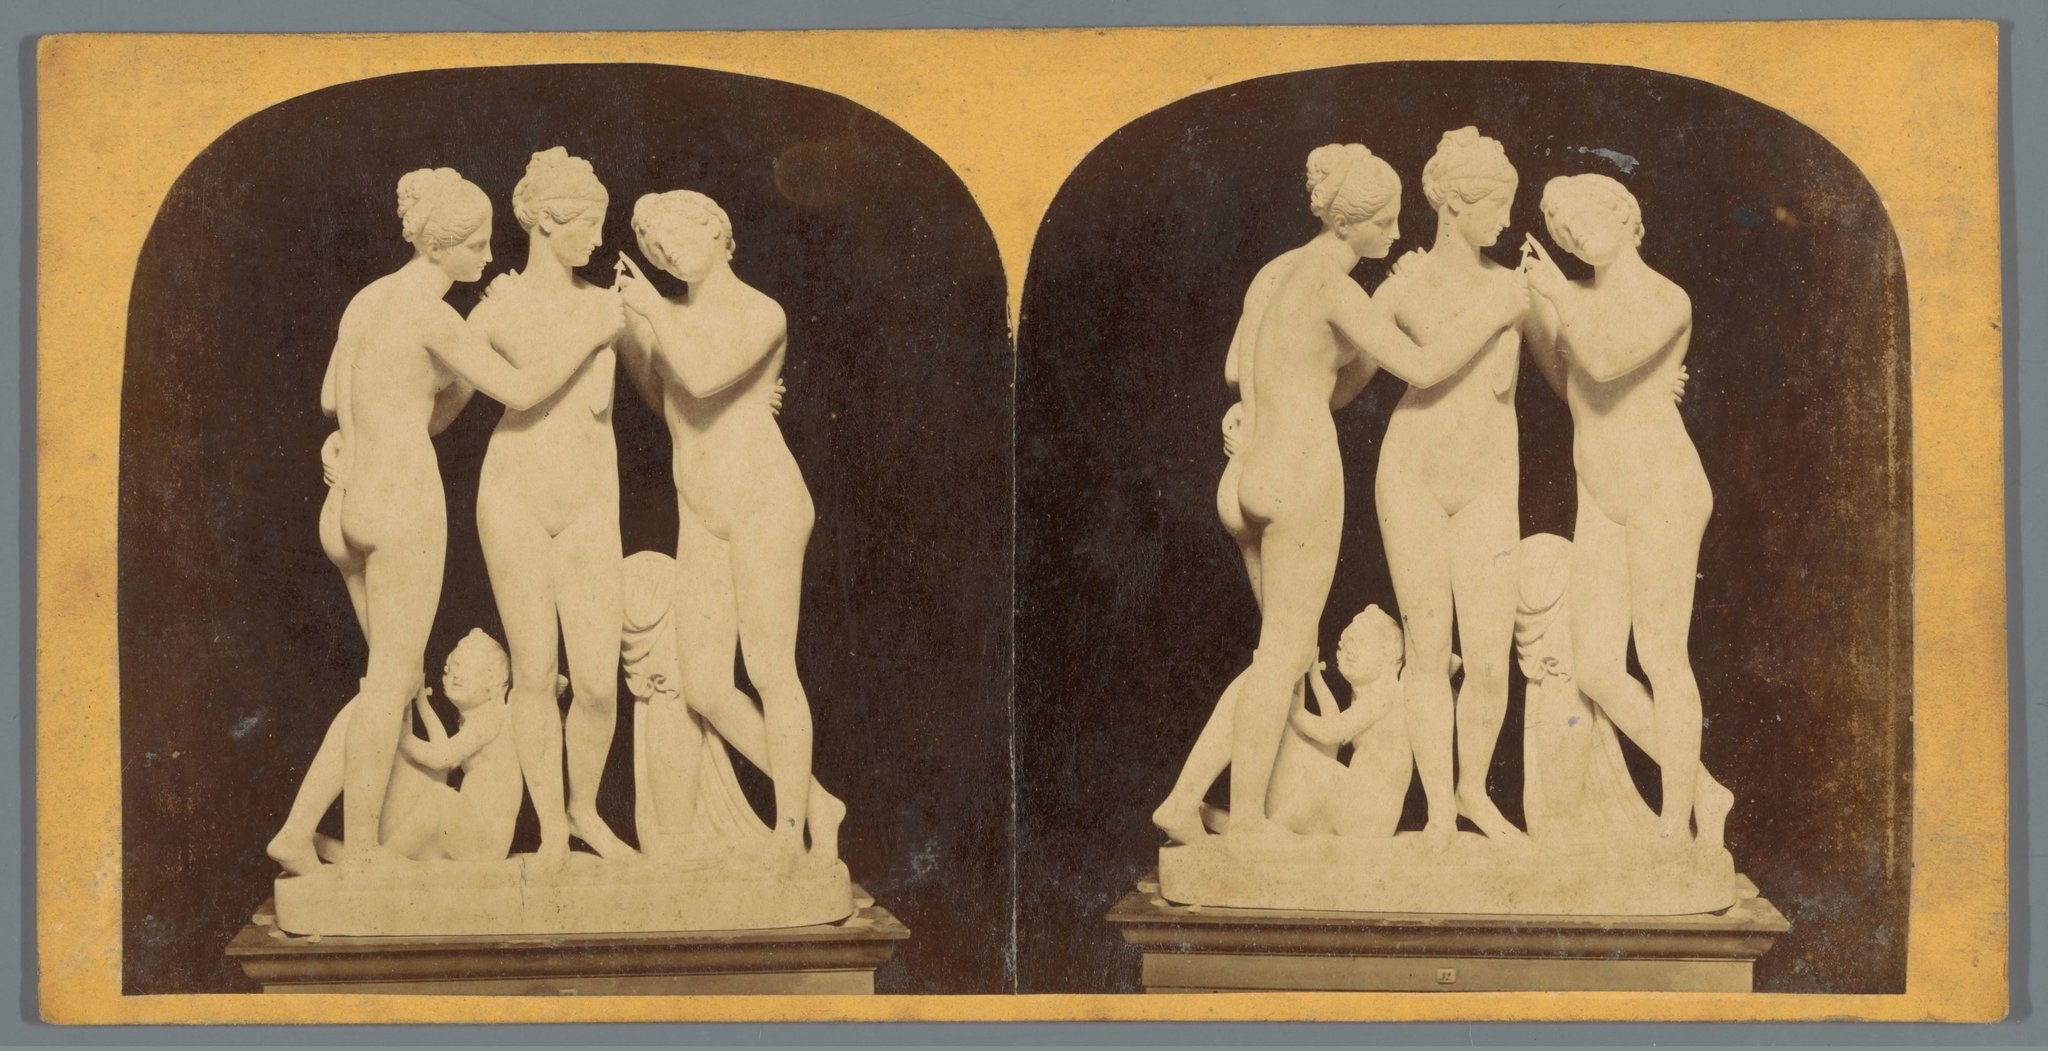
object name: stereograph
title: Thorvaldsen. Gratierne og Amor. / Les grâces et l'Amour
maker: bertel thorvaldsen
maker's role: draughtsman, sculptor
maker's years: 1768-1844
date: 1862-1884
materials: cardboard, paper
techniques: albumen print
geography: copenhagen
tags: graces (charites), generally three in number; 'gratie' (ripa), sculpture, copenhagen (city)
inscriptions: inscription: ‘Original.’, number: ‘234.’, address: ‘FOTOGRAFISK INSTITUT/ Budtz Müller & Co./ Bredgade No. 21, Kjöbenhavn.’